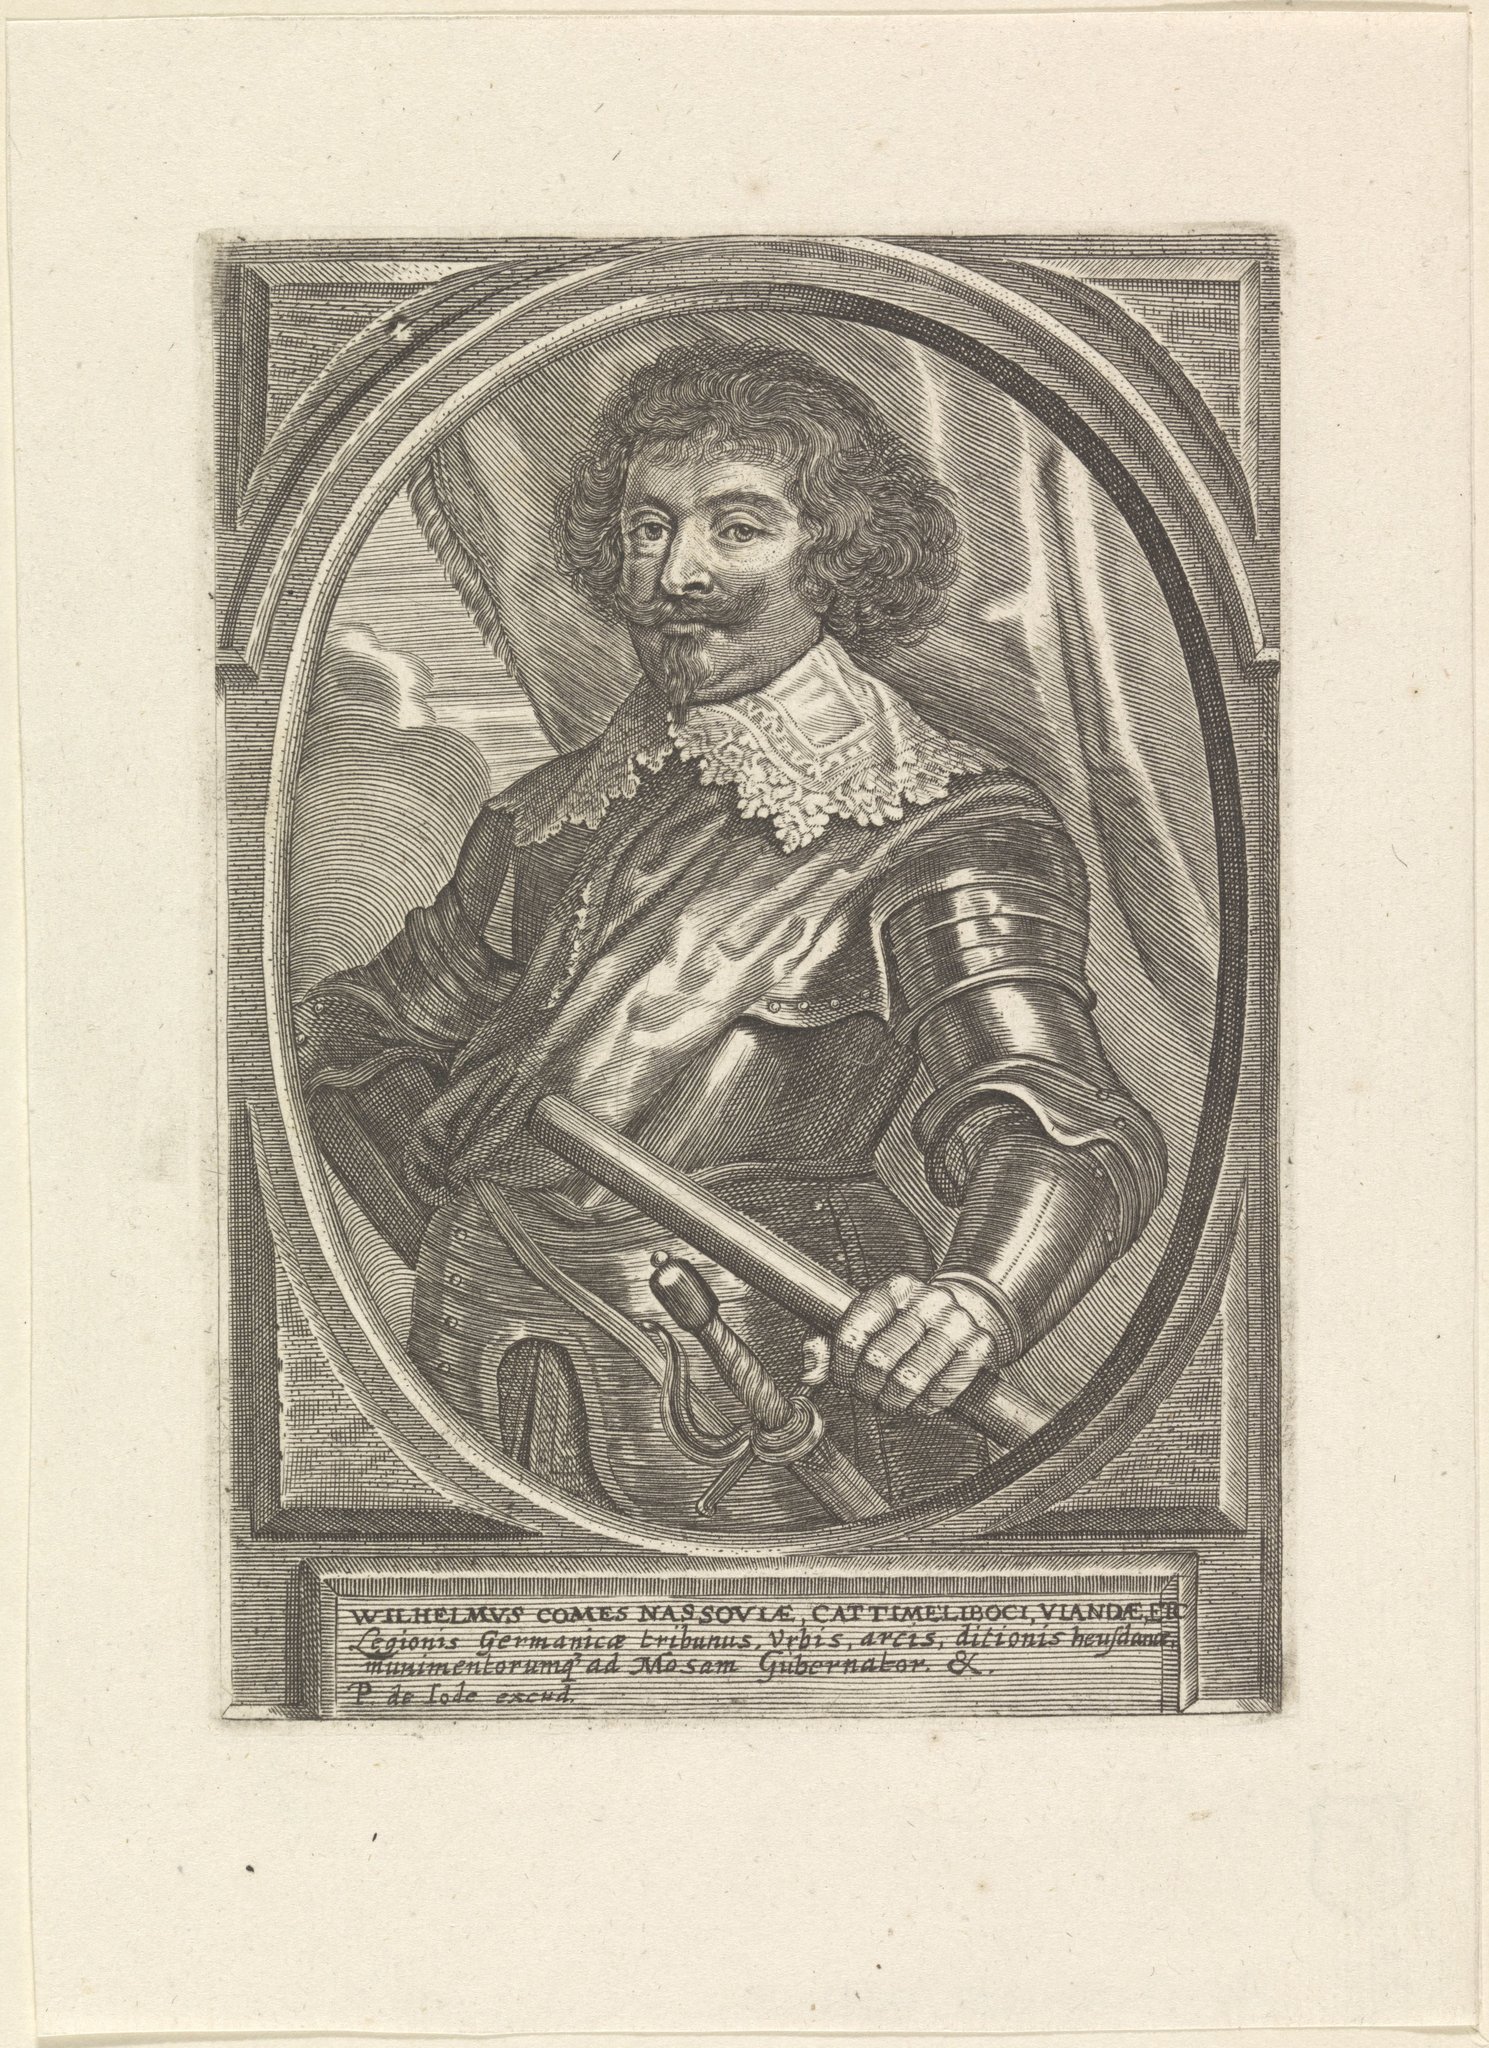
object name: print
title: Portret van Willem, graaf van Nassau-Siegen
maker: pieter de jode (ii)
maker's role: draughtsman, print maker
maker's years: 1606-1674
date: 1628-1670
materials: paper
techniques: engraving, etching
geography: antwerp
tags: dillenburg, willem graaf van nassau-siegen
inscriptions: collector's mark: Lugt 963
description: De hier vermelde titel verwijst naar de hoogst verkregen titel van de geportretteerde, niet per se naar de titel die de geportretteerde op deze voorstelling draagt.